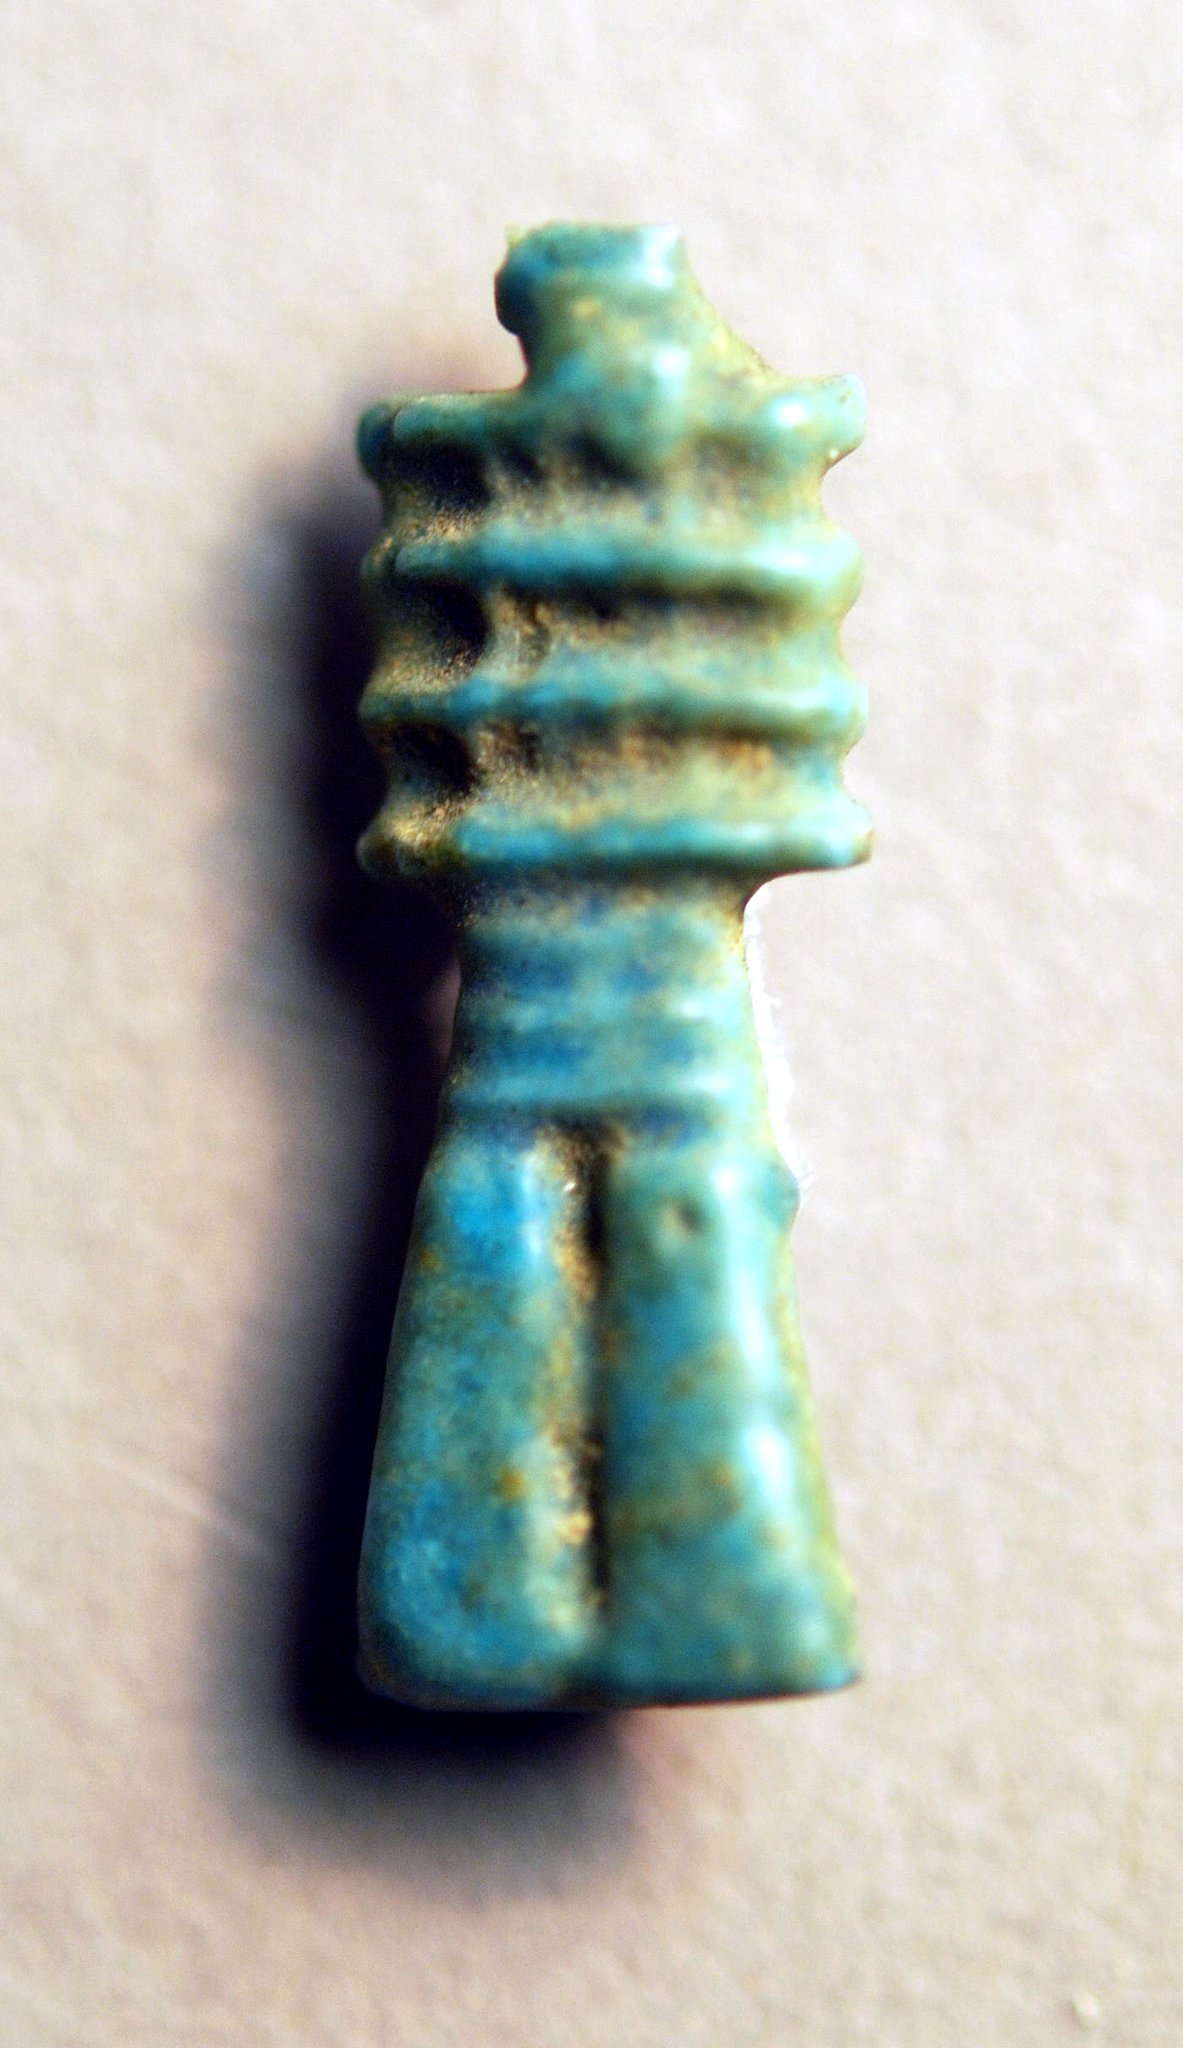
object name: amulet, djed pillar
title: Djed Amulet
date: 1390-1352 BCE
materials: faience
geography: egypt